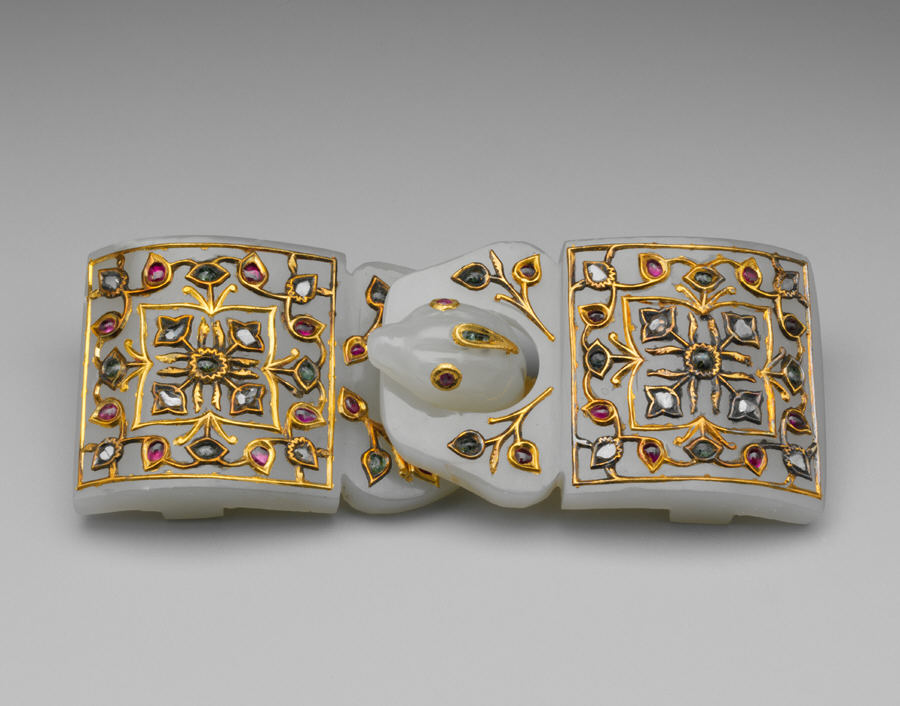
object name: belt buckle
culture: chinese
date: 1701-1900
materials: enamel, gold, jade, stone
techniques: inlay